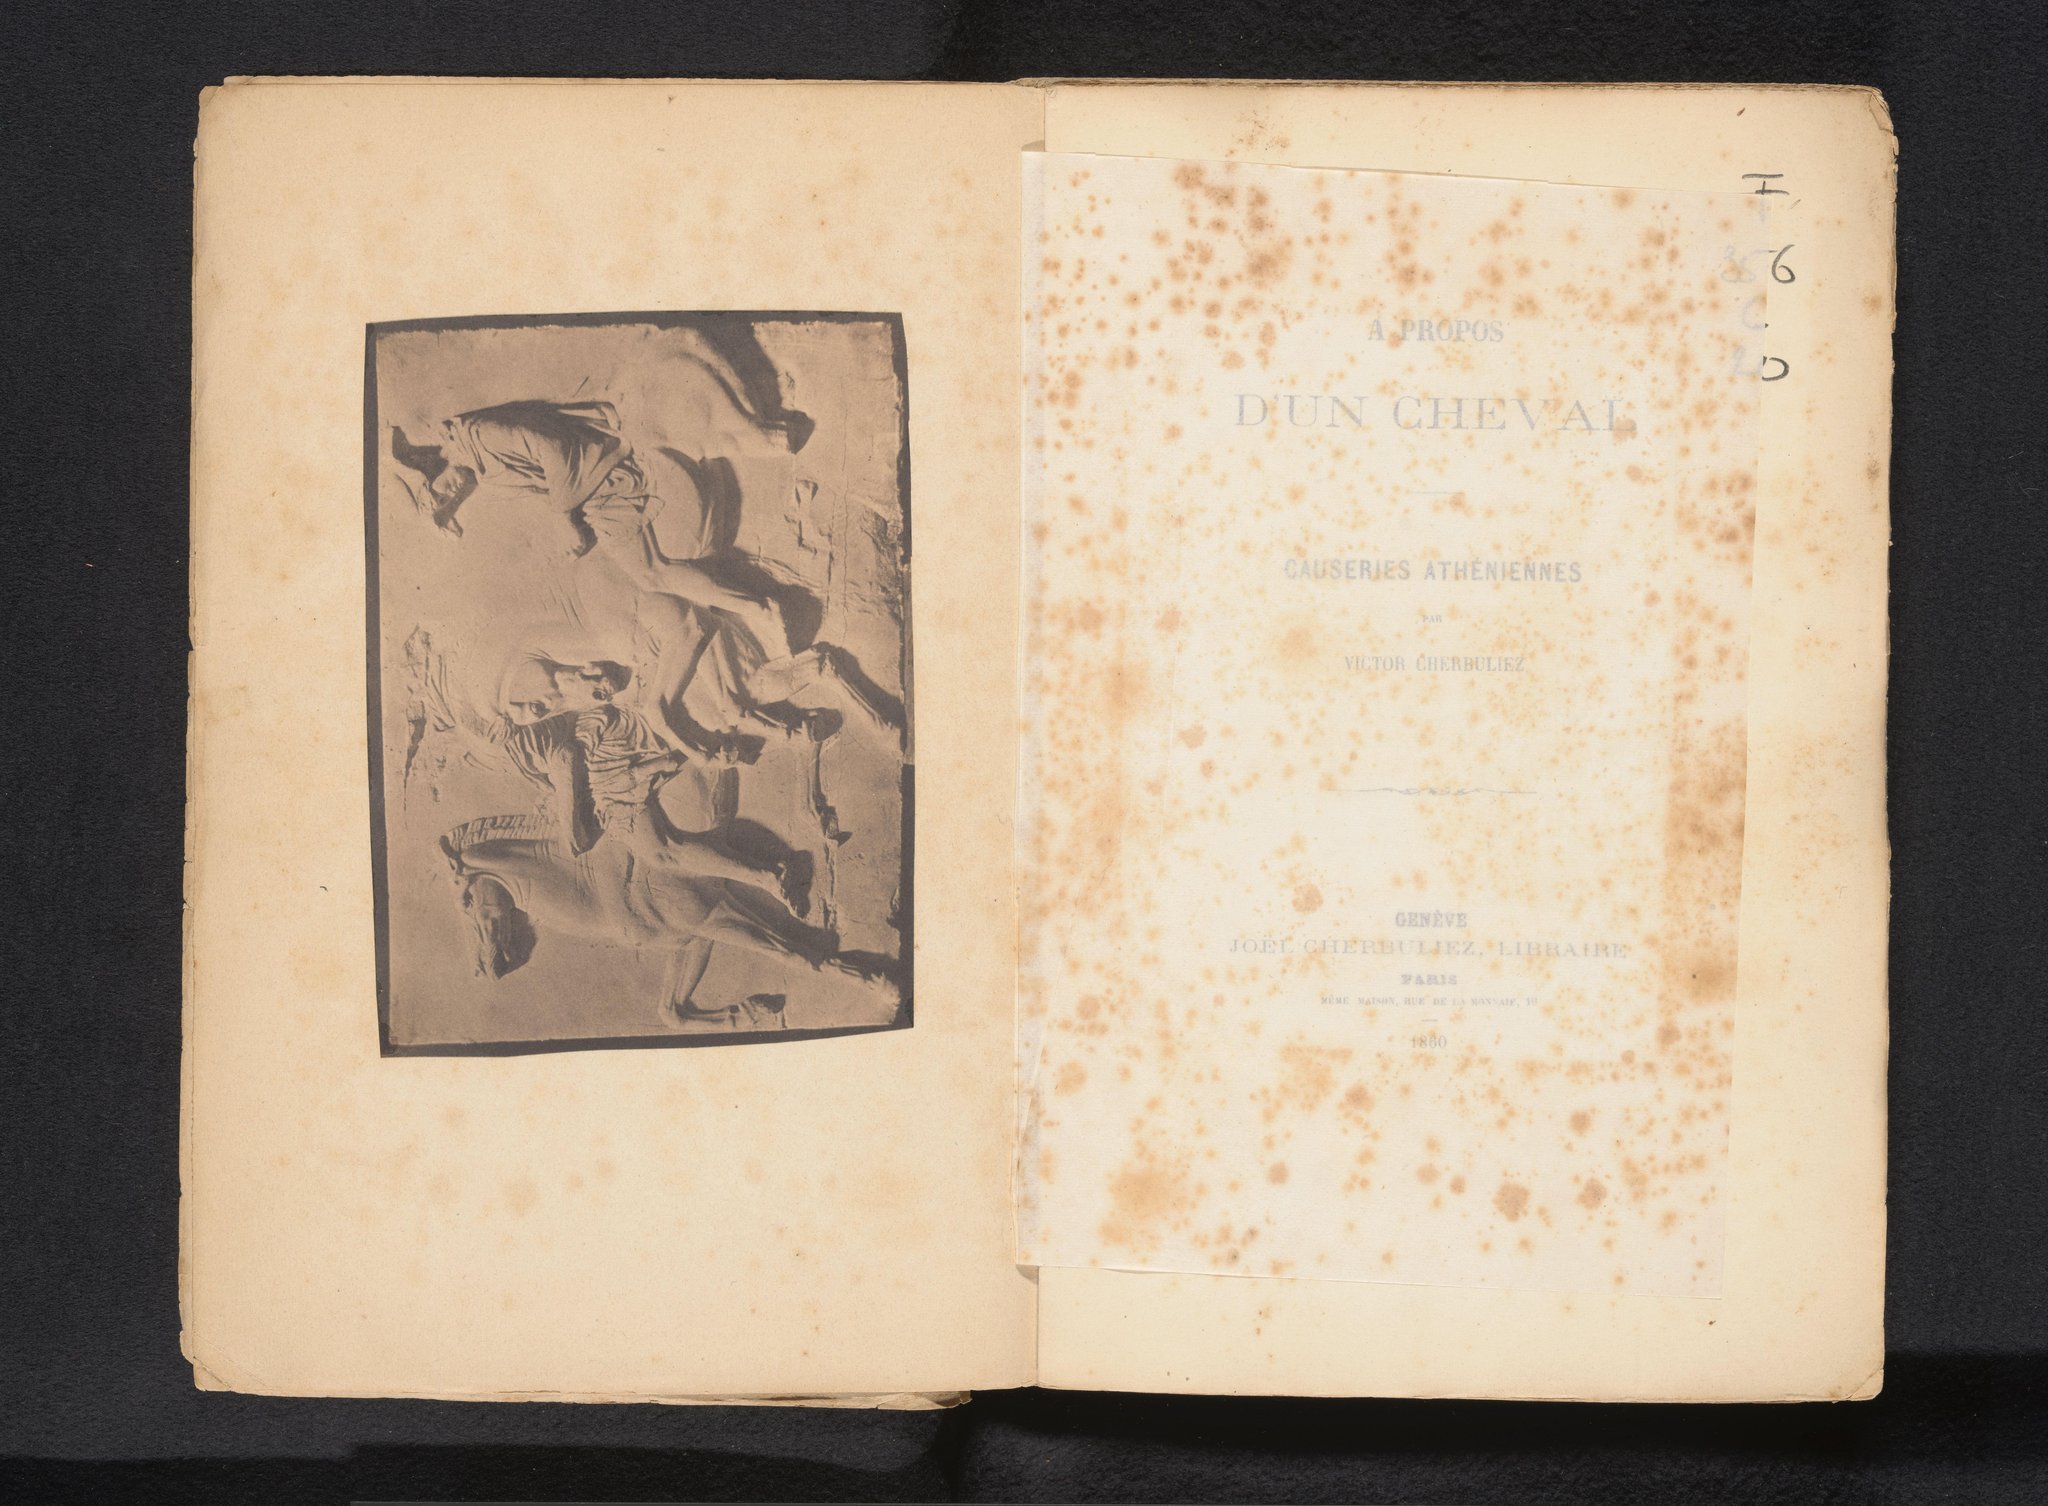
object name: page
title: Reliëf van ruiters op het Parthenonfries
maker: Anonymous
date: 1850-1860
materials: photographic support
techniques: salted paper print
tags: riding a horse, ass, or mule; rider, horseman, sculpture (+ relief ~ sculpture)